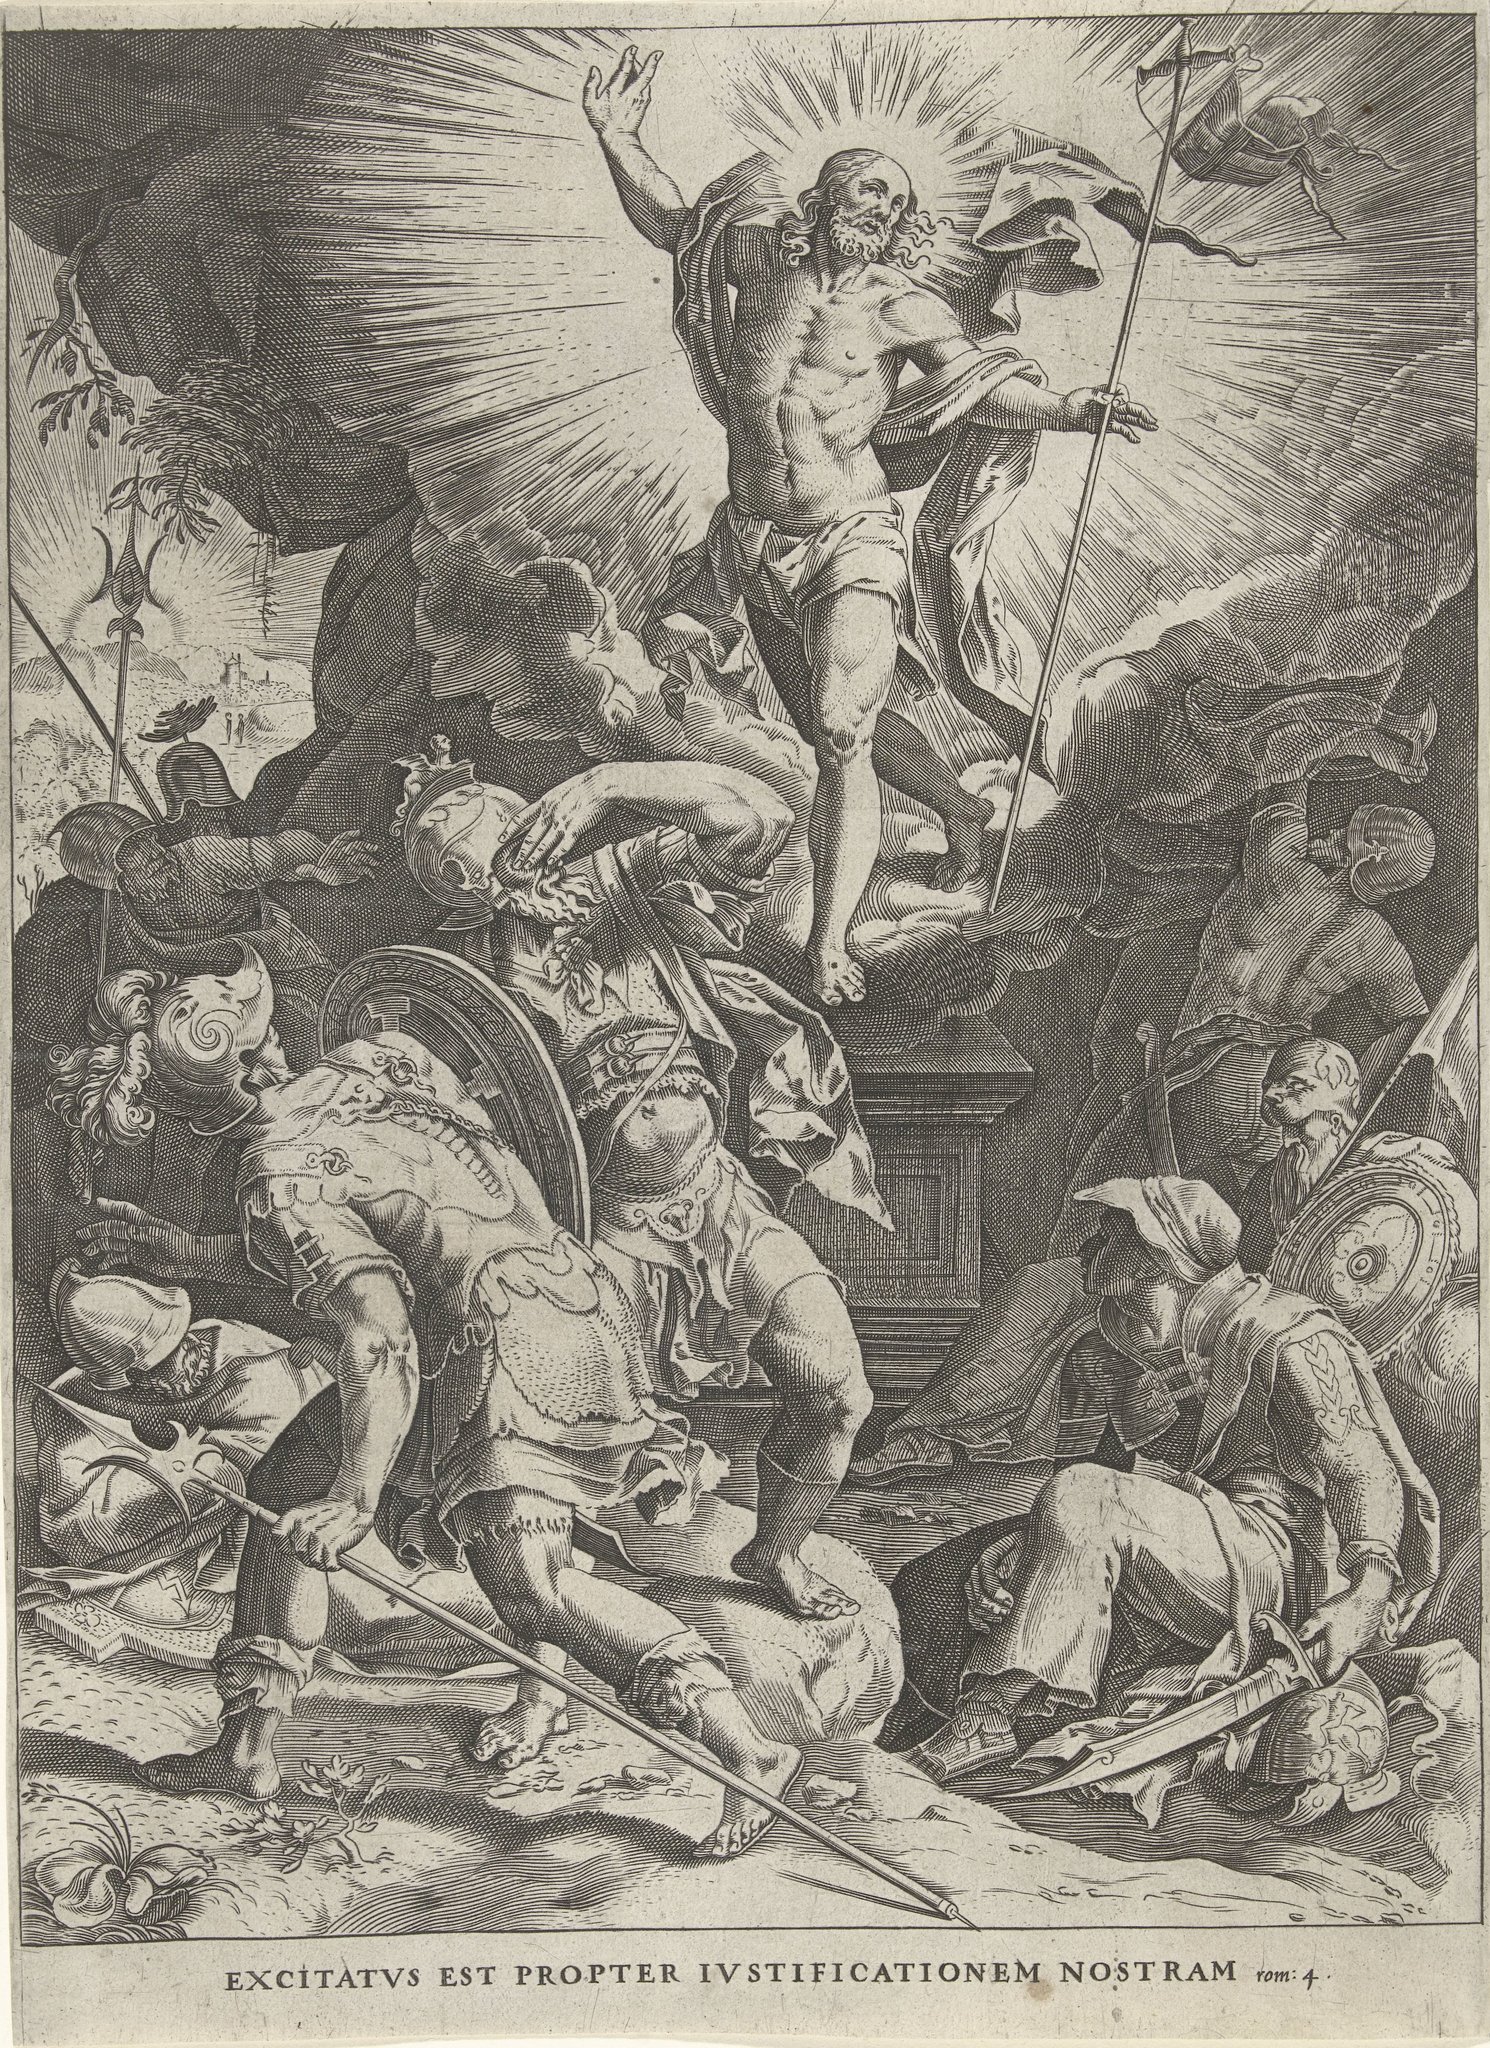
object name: print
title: Opstanding van Christus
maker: Anonymous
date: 1569-1619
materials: paper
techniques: engraving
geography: rome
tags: christ, usually holding a banner, arises from the grave; often combined with sleeping and/or frightened soldiers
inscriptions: collector's mark: Lugt 2228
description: Christus verrijst uit het graf. Soldaten snellen weg en bedekken hun ogen om ze te beschermen voor het licht, dat van Christus afstraalt. Christus staat in een wolk boven het graf met een vaandel in zijn hand.